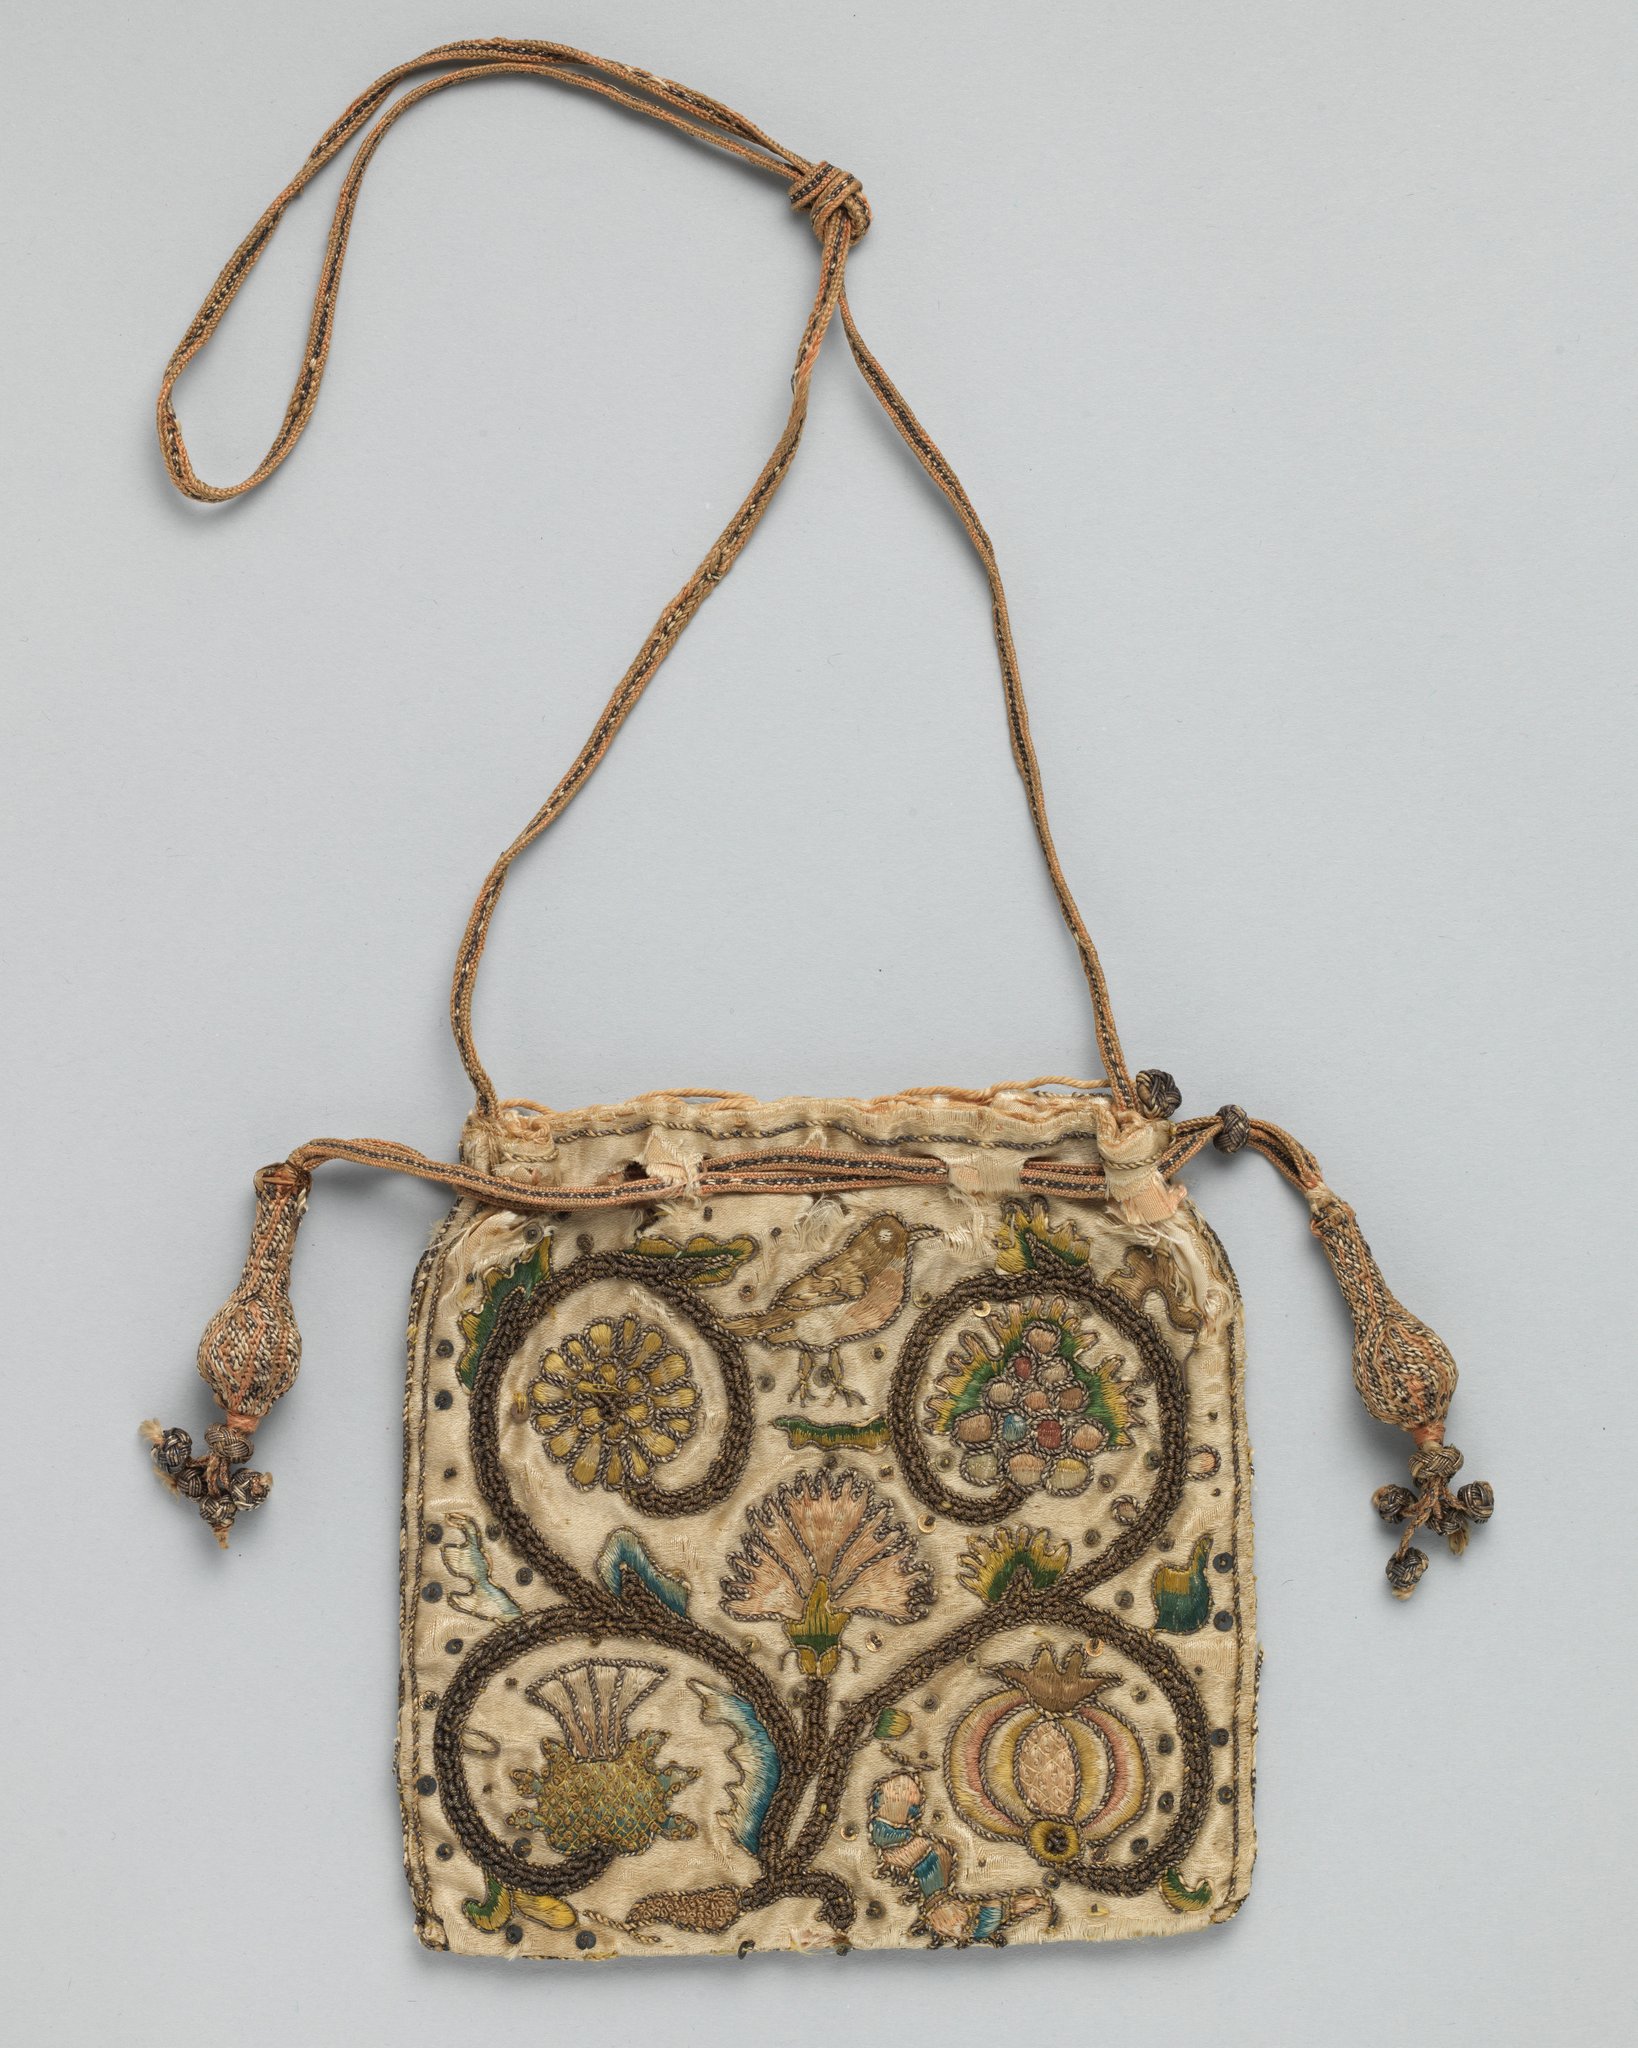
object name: bag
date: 1601-1650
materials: metal thread, silk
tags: birds,flowers